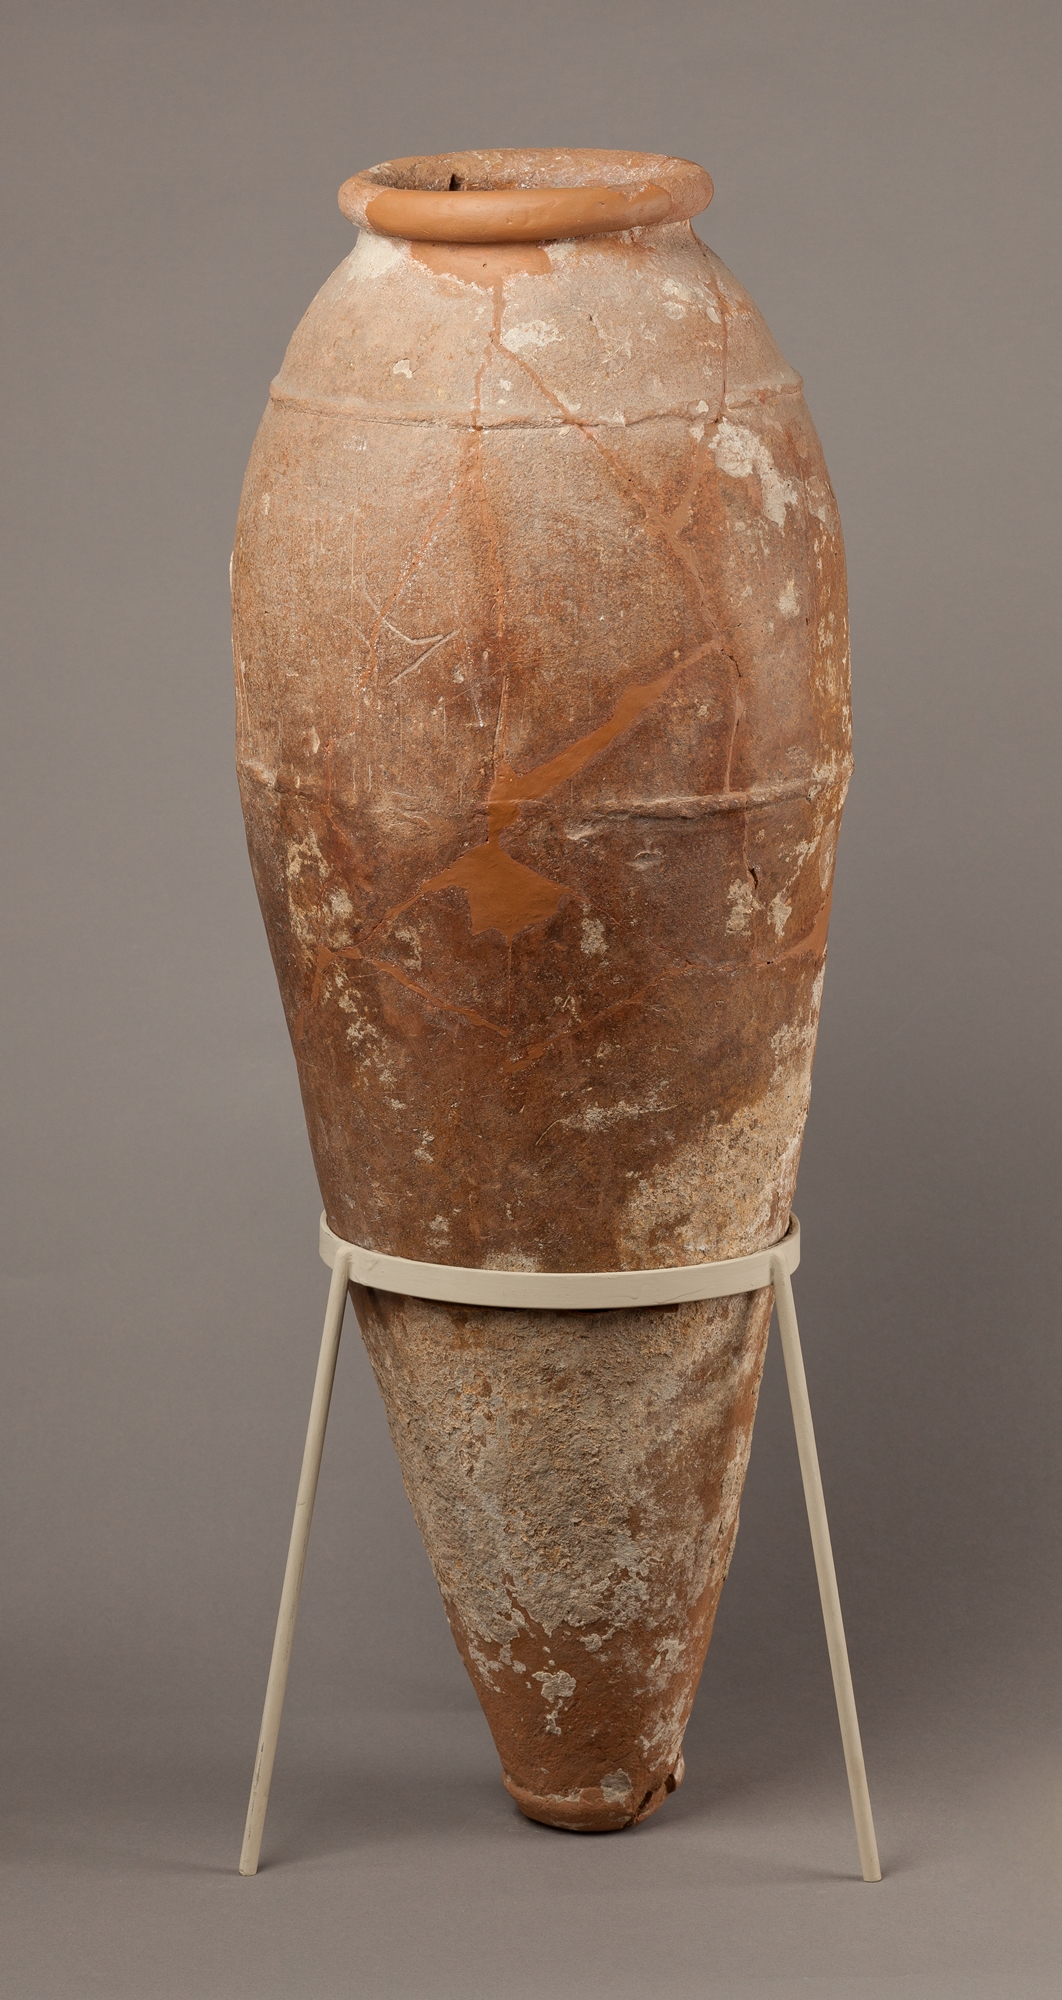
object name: jar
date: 3100-2649 BCE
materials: pottery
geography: egypt